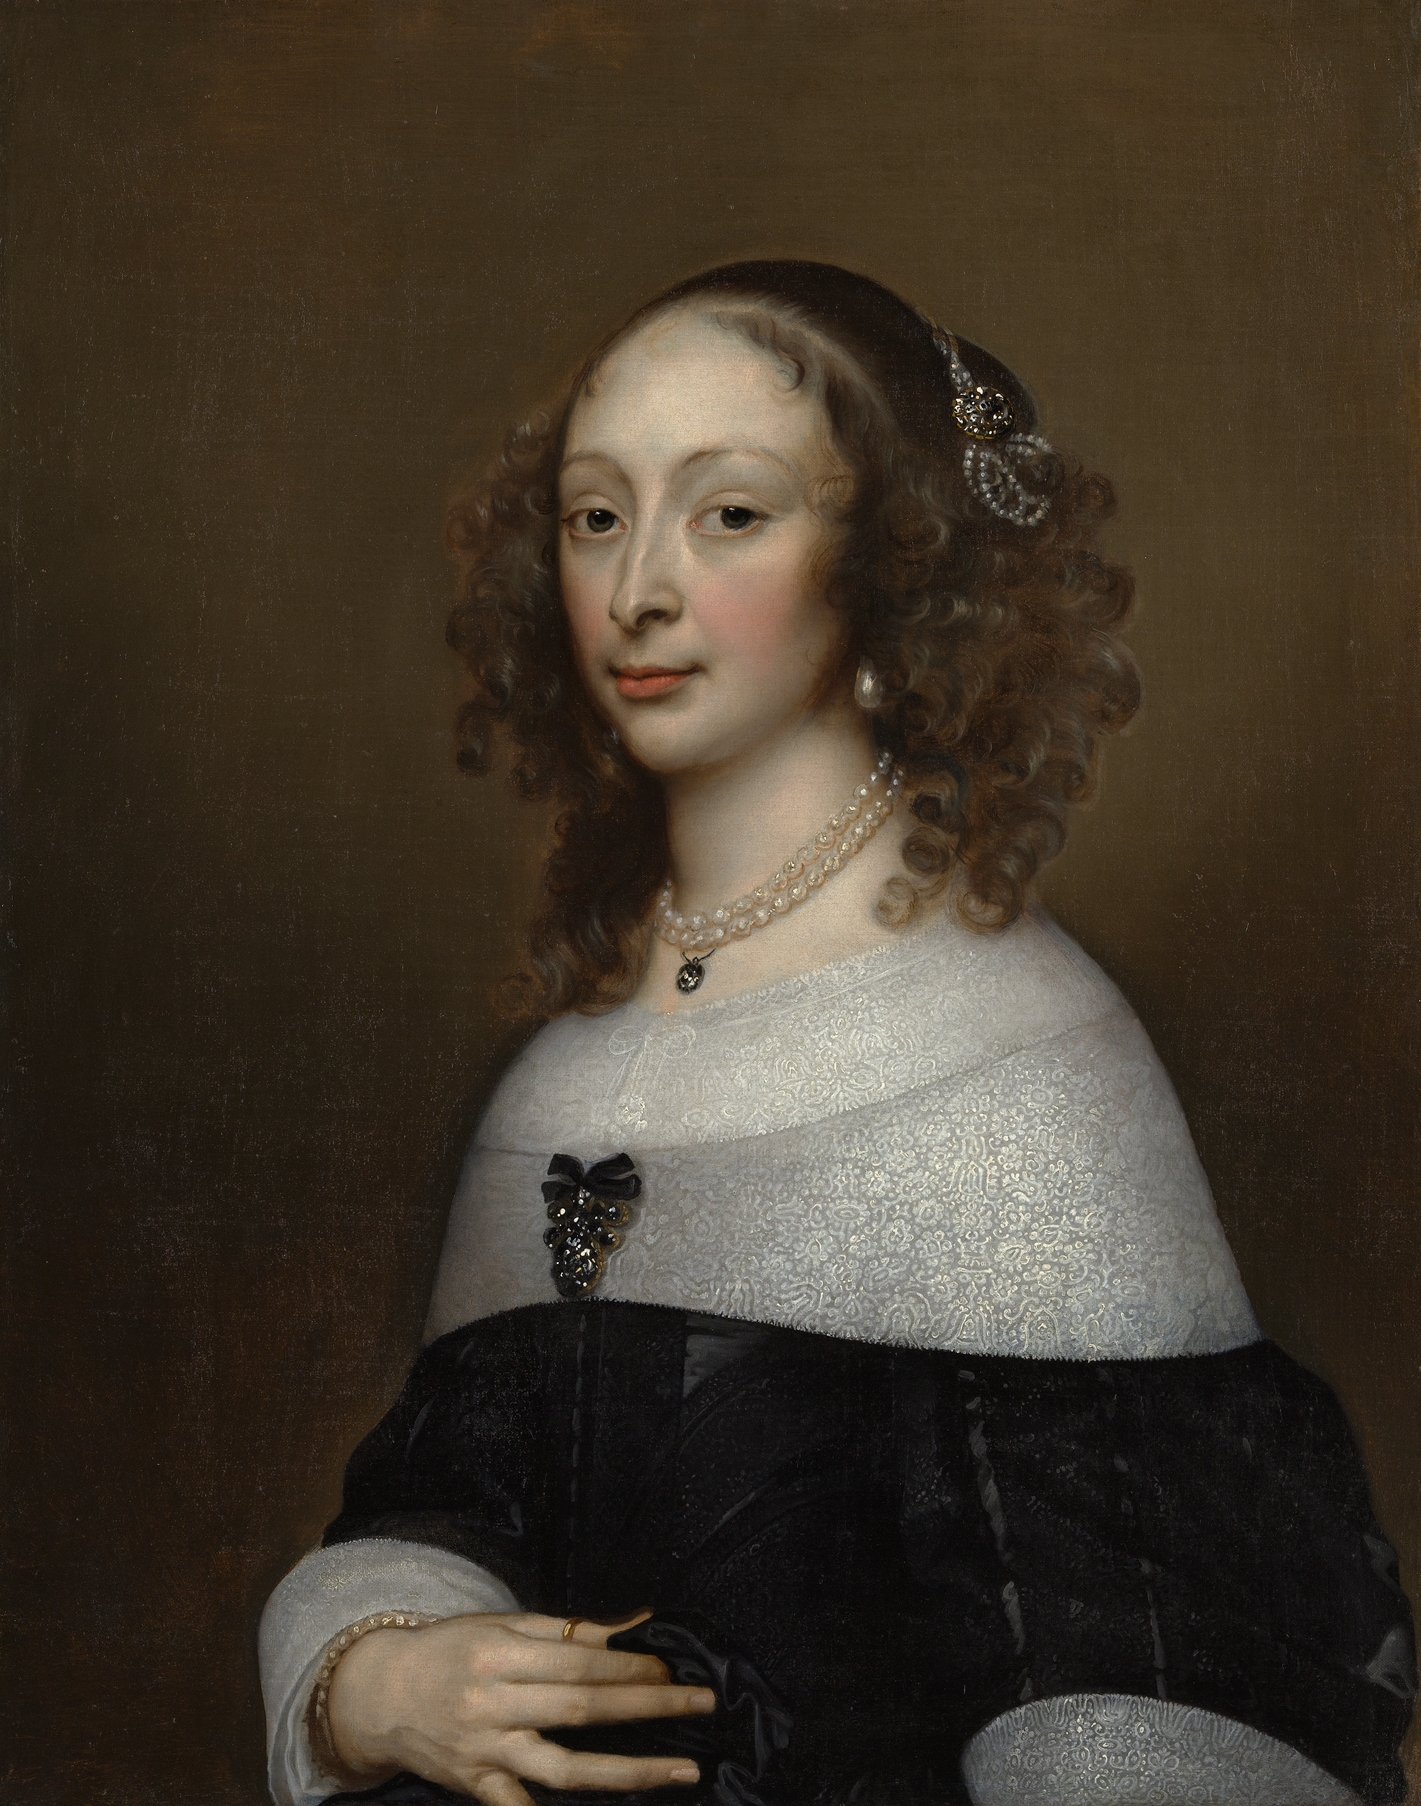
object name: painting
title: Portrait of a Woman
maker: adriaen hanneman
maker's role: artist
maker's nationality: dutch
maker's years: 1603-1671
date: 1653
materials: canvas, oil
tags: portraits,women